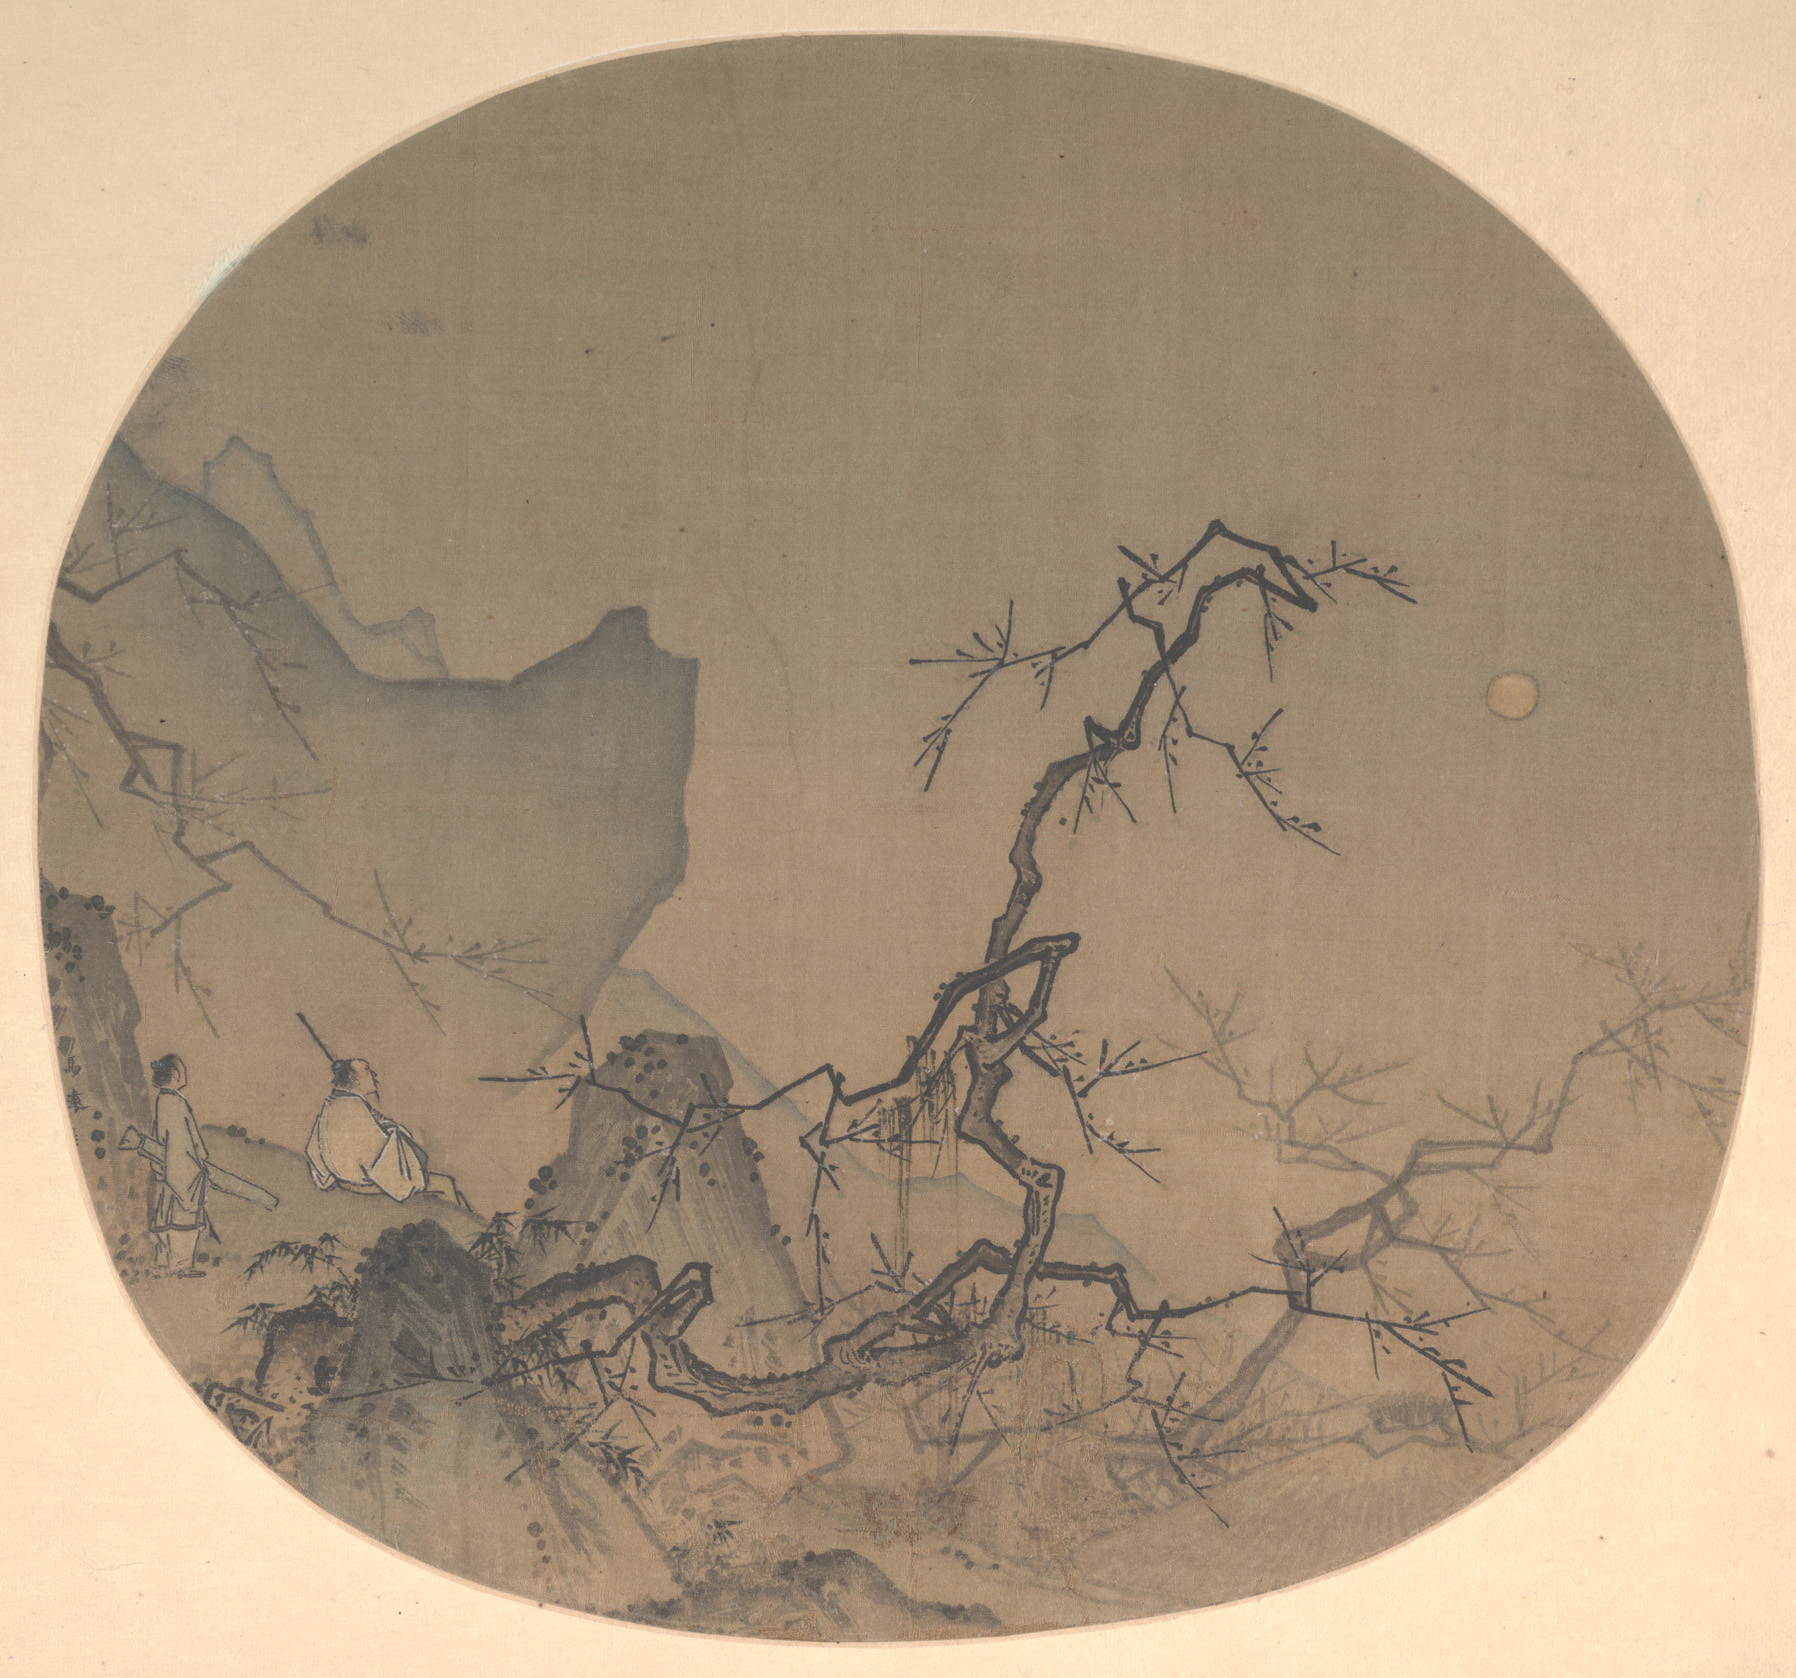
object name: folding fan mounted a an album leaf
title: Viewing plum blossoms by moonlight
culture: chinese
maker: ma yuan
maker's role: artist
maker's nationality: chinese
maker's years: 1190-1225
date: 1201-1233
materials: ink, silk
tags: men,moon,trees